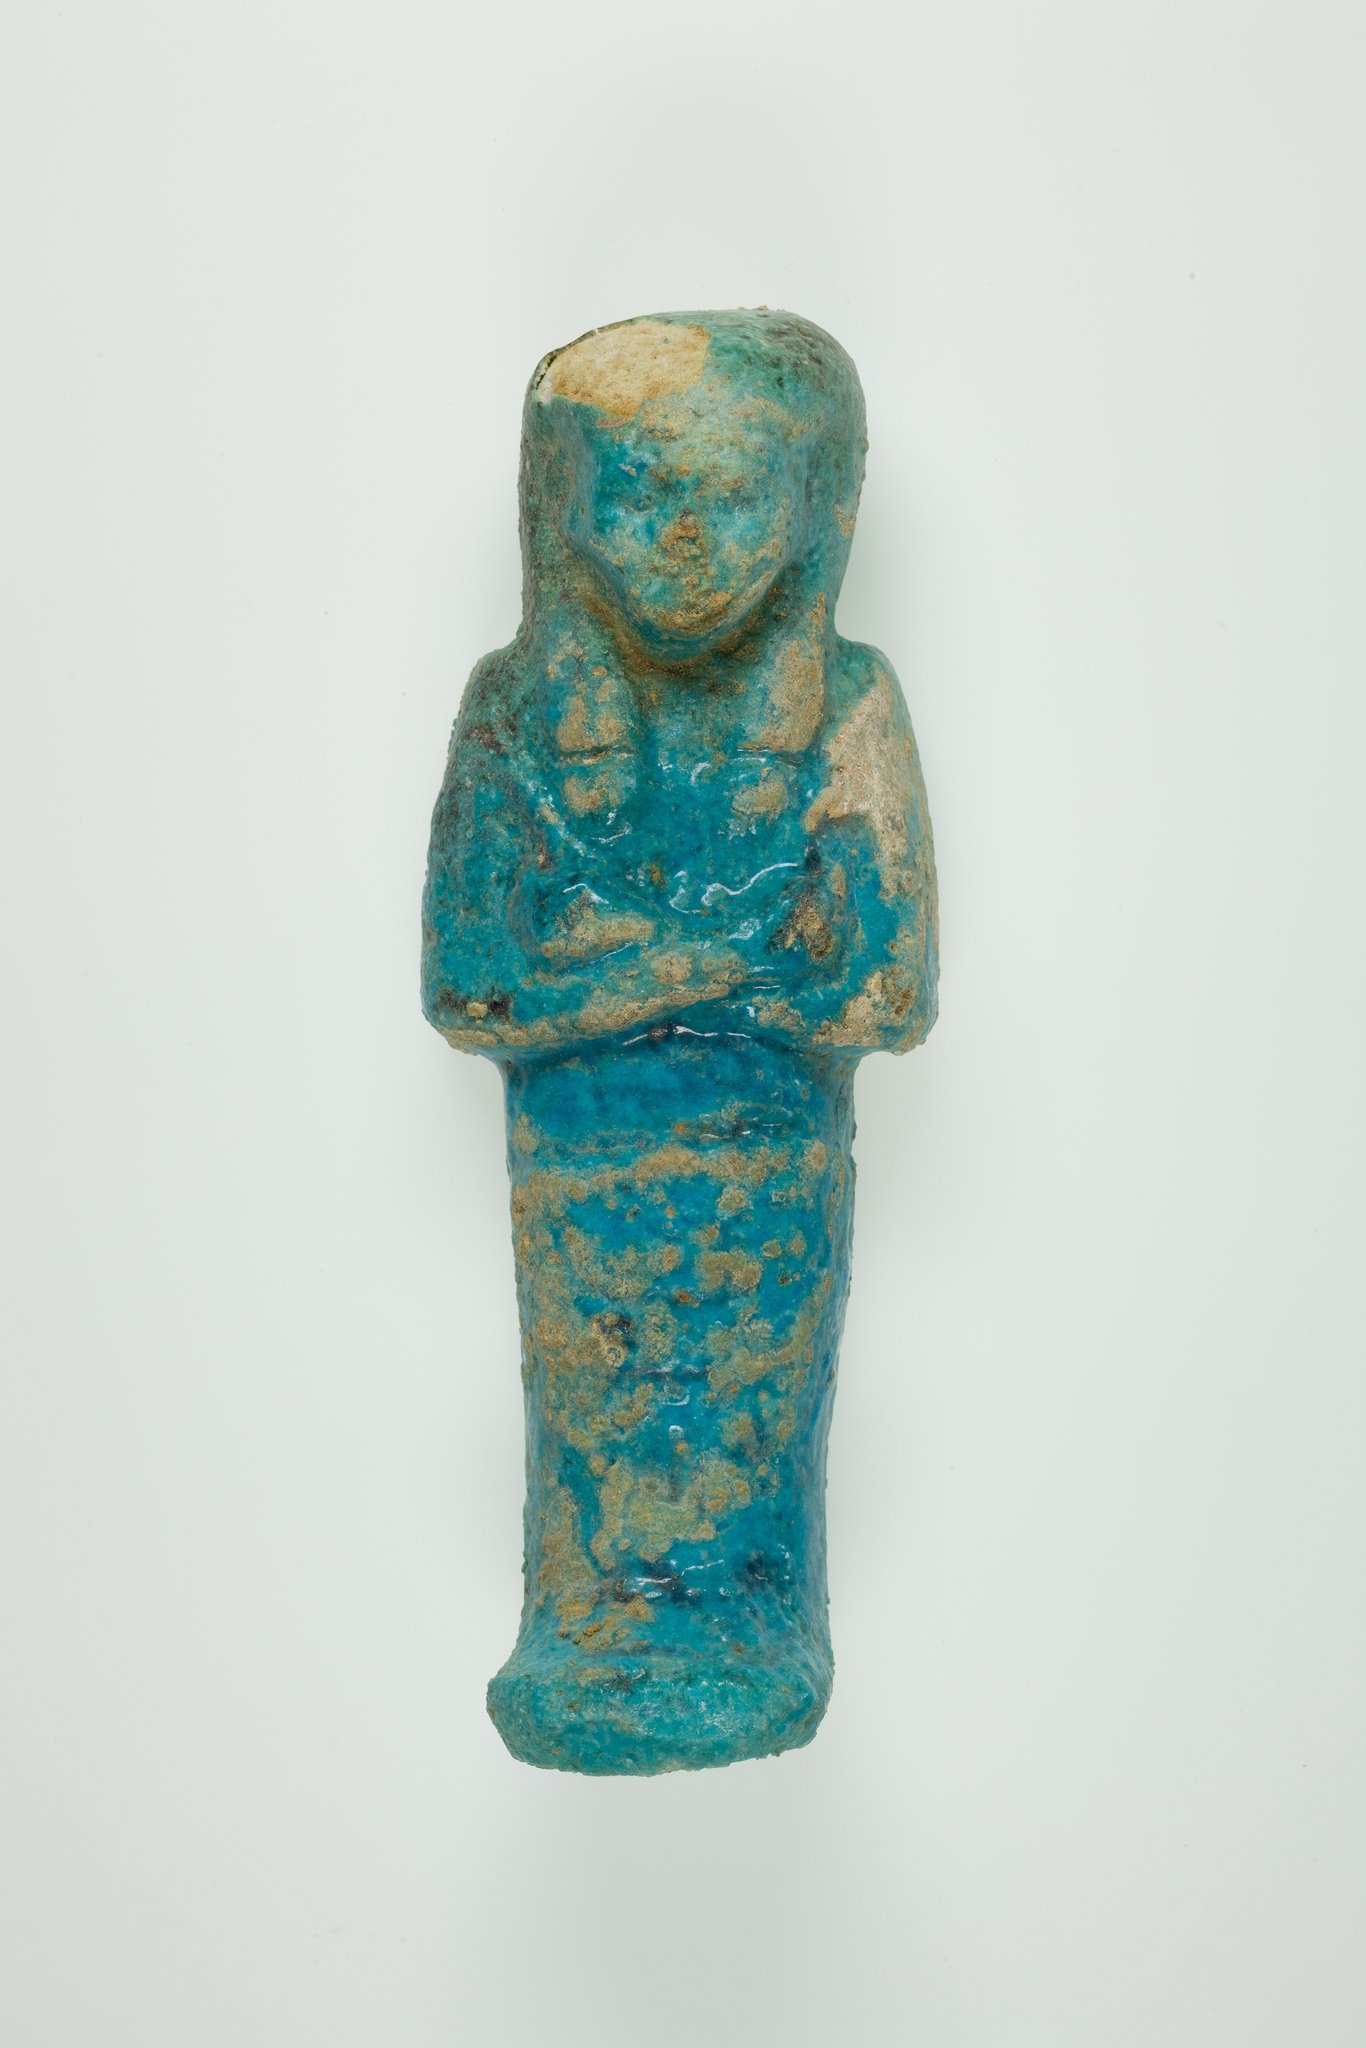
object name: worker shabti, henettawy c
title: Worker Shabti of Henettawy (C), Daughter of Isetemkheb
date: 990-970 BCE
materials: faience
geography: egypt